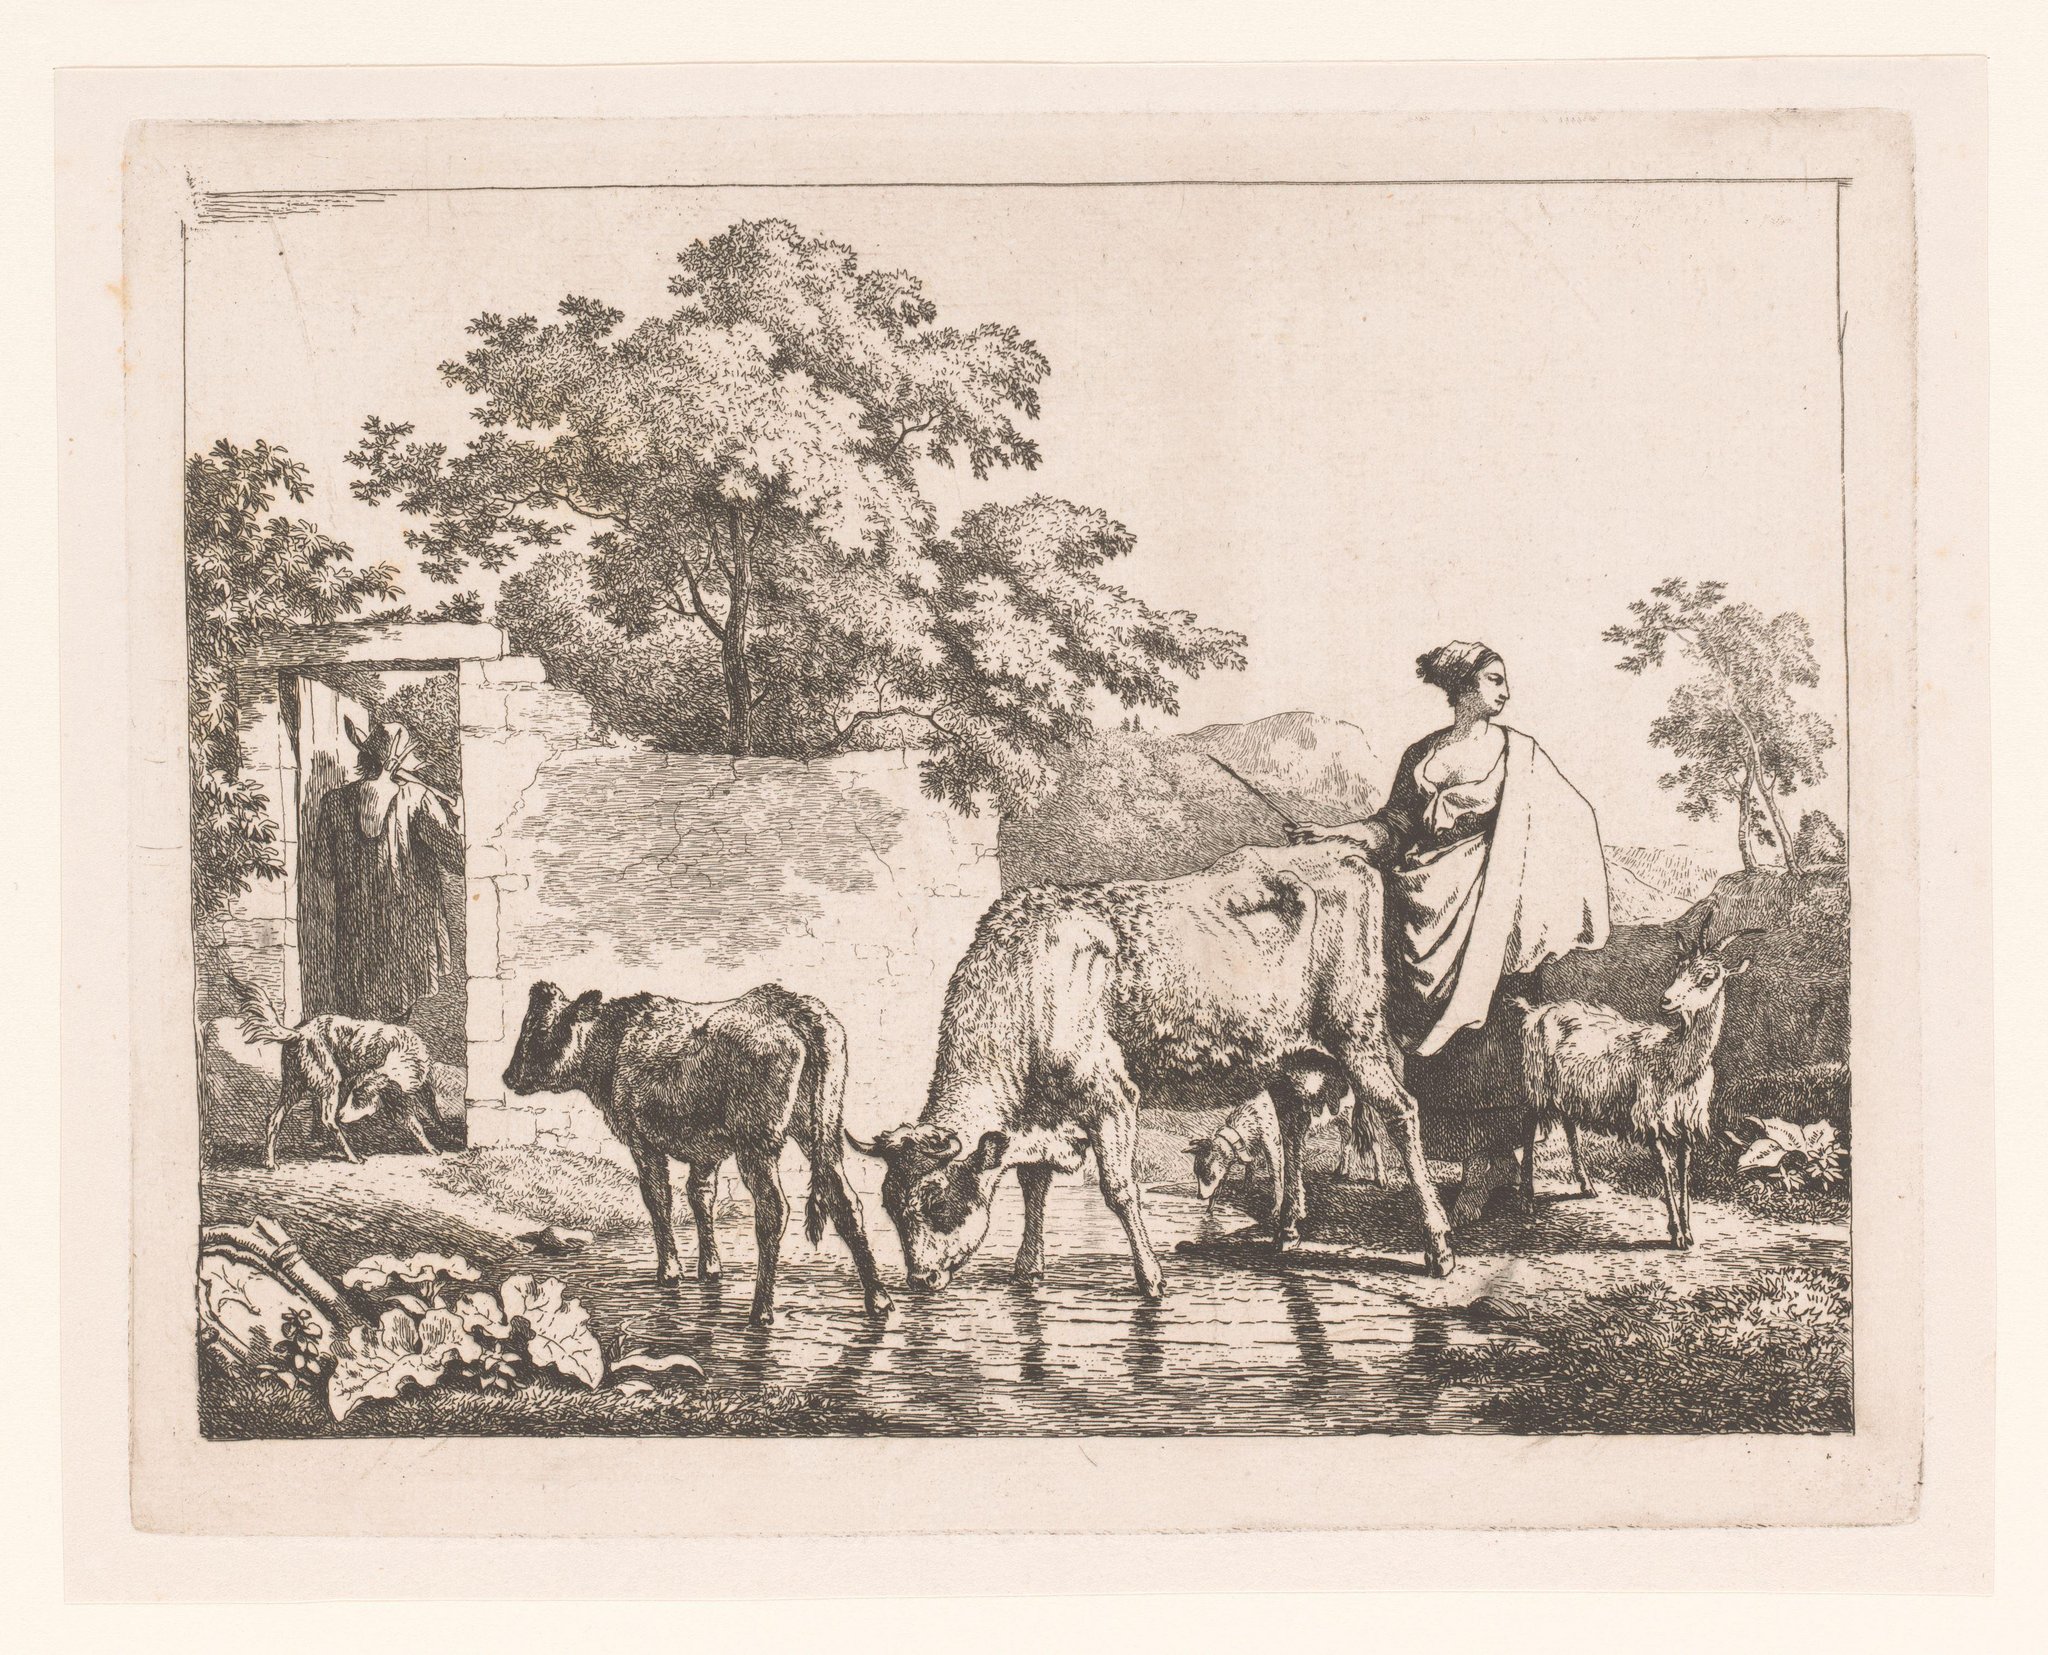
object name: print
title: Landschap met vee en herders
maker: jean louis demarne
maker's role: draughtsman, painter, print maker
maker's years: 1752-1829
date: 1762-1829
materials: paper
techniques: etching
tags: cow, herding, herdsman, herdswoman, shepherd, shepherdess, cowherd, etc., landscapes with waters, waterscapes, seascapes (in the temperate zone), landscape with ruins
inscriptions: collector's mark: Lugt 2228